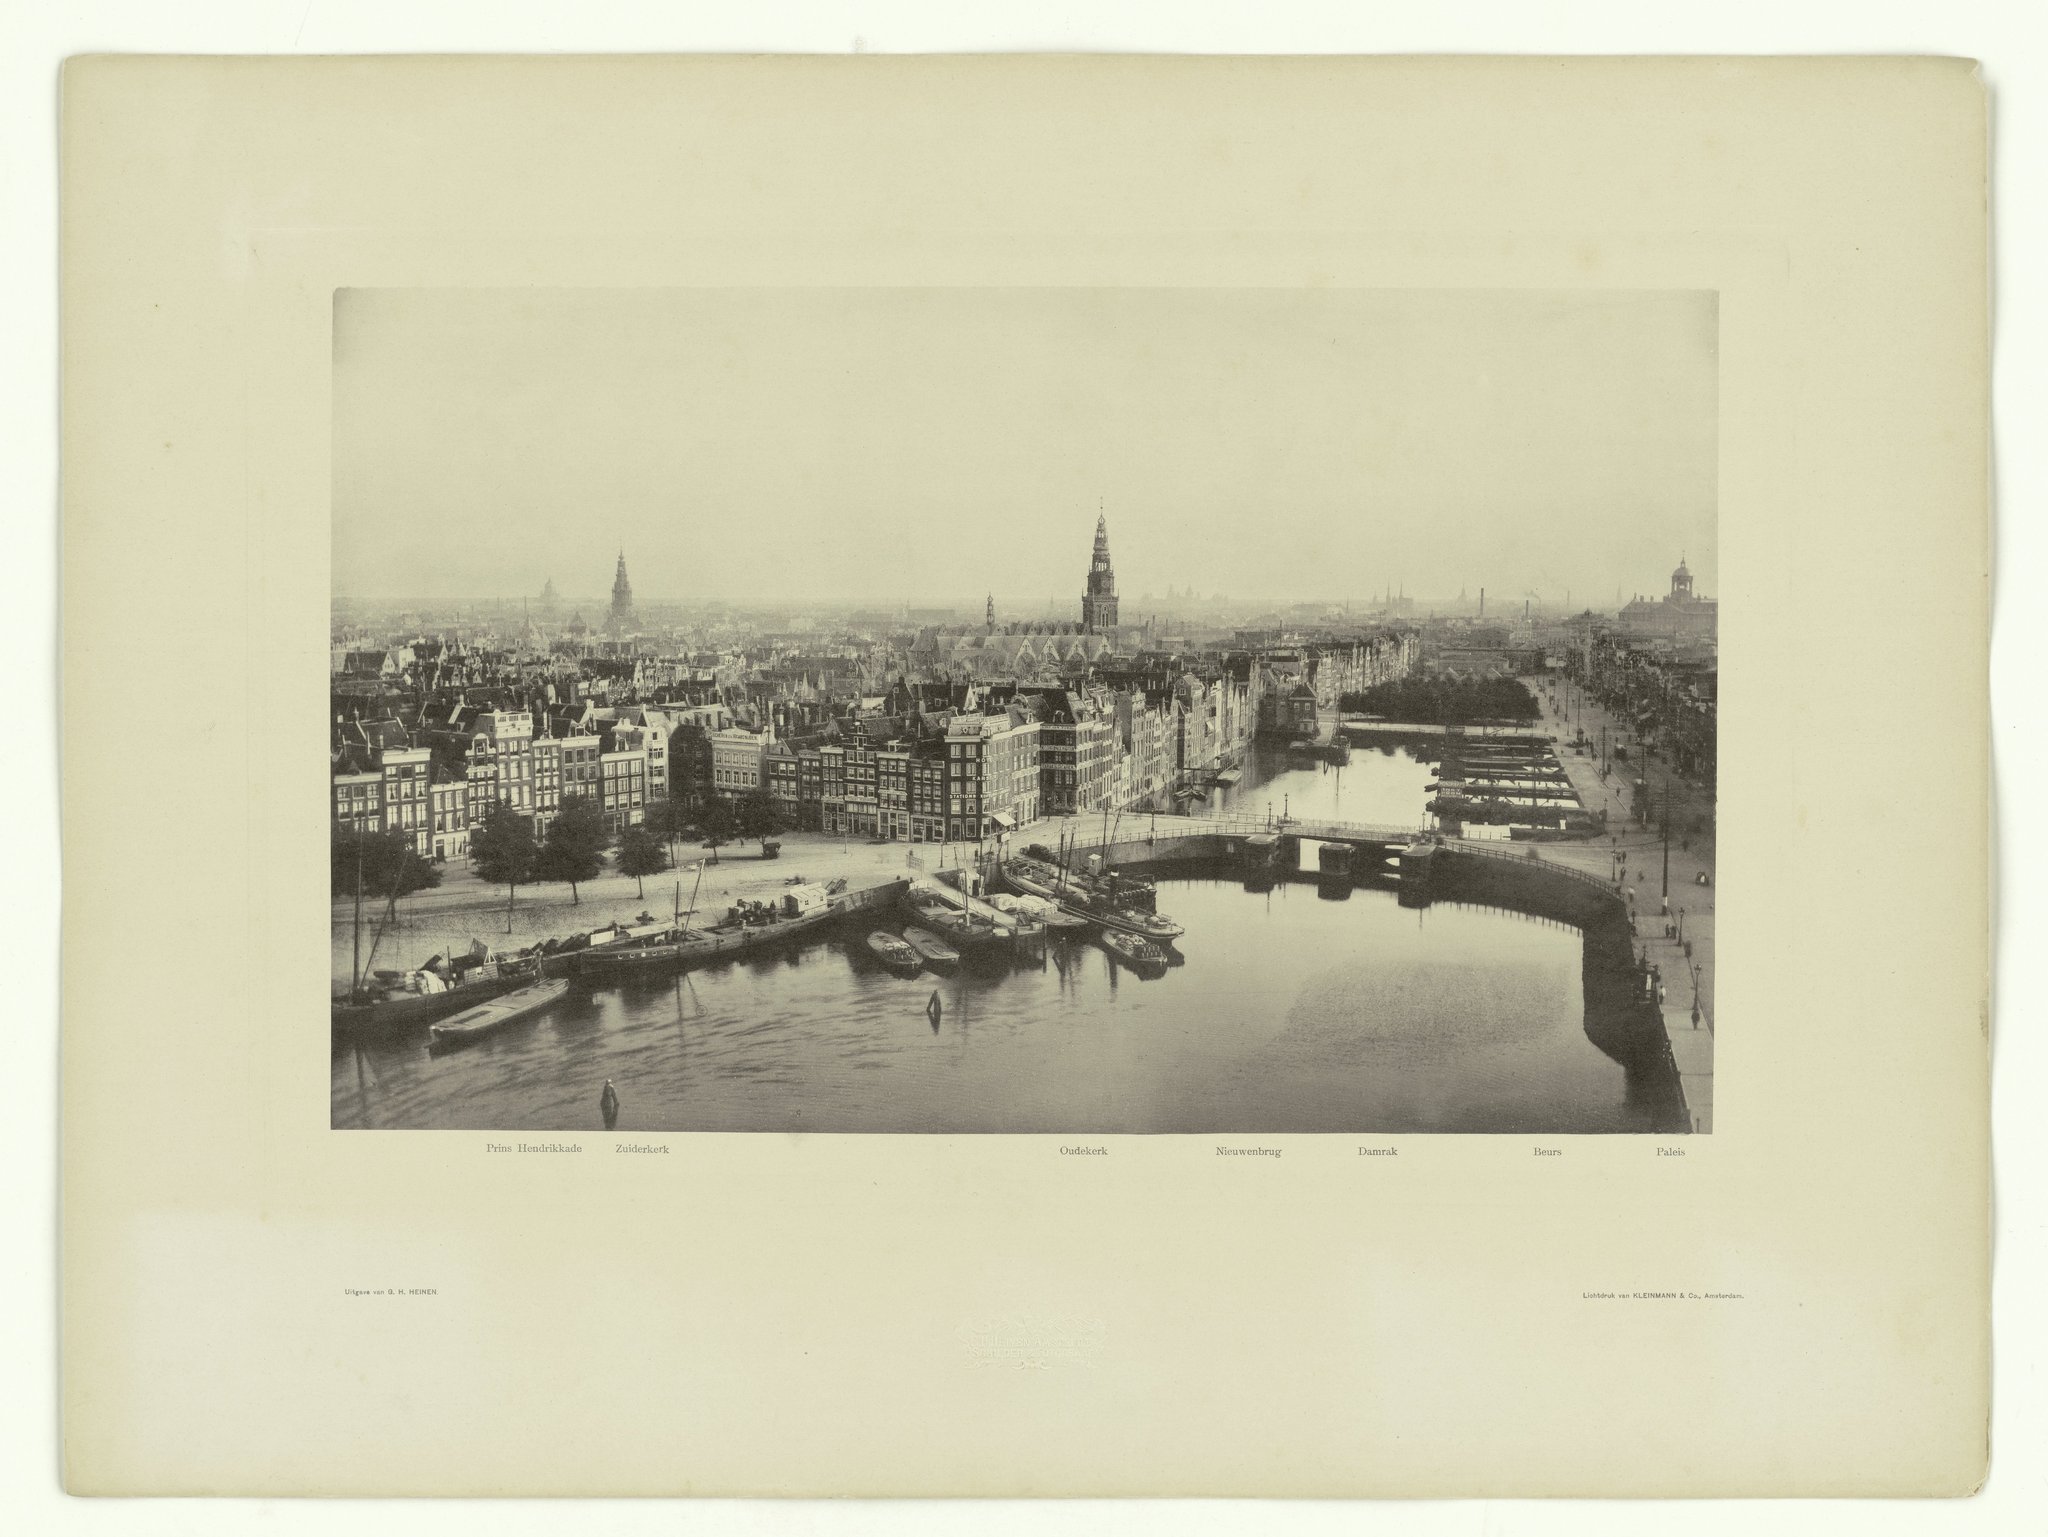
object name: photomechanical print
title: Damrak, gezien vanaf het Centraal Station, Amsterdam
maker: gerrit hendricus heinen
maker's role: painter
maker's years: 1851-1930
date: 1889-1894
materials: paper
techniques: photograph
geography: amsterdam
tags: urban housing, city-view in general; 'veduta', canals, waters (in city)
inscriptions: check stamp: ‘G.H. Heinen Amsterdam/ Schilder & Fotograaf’